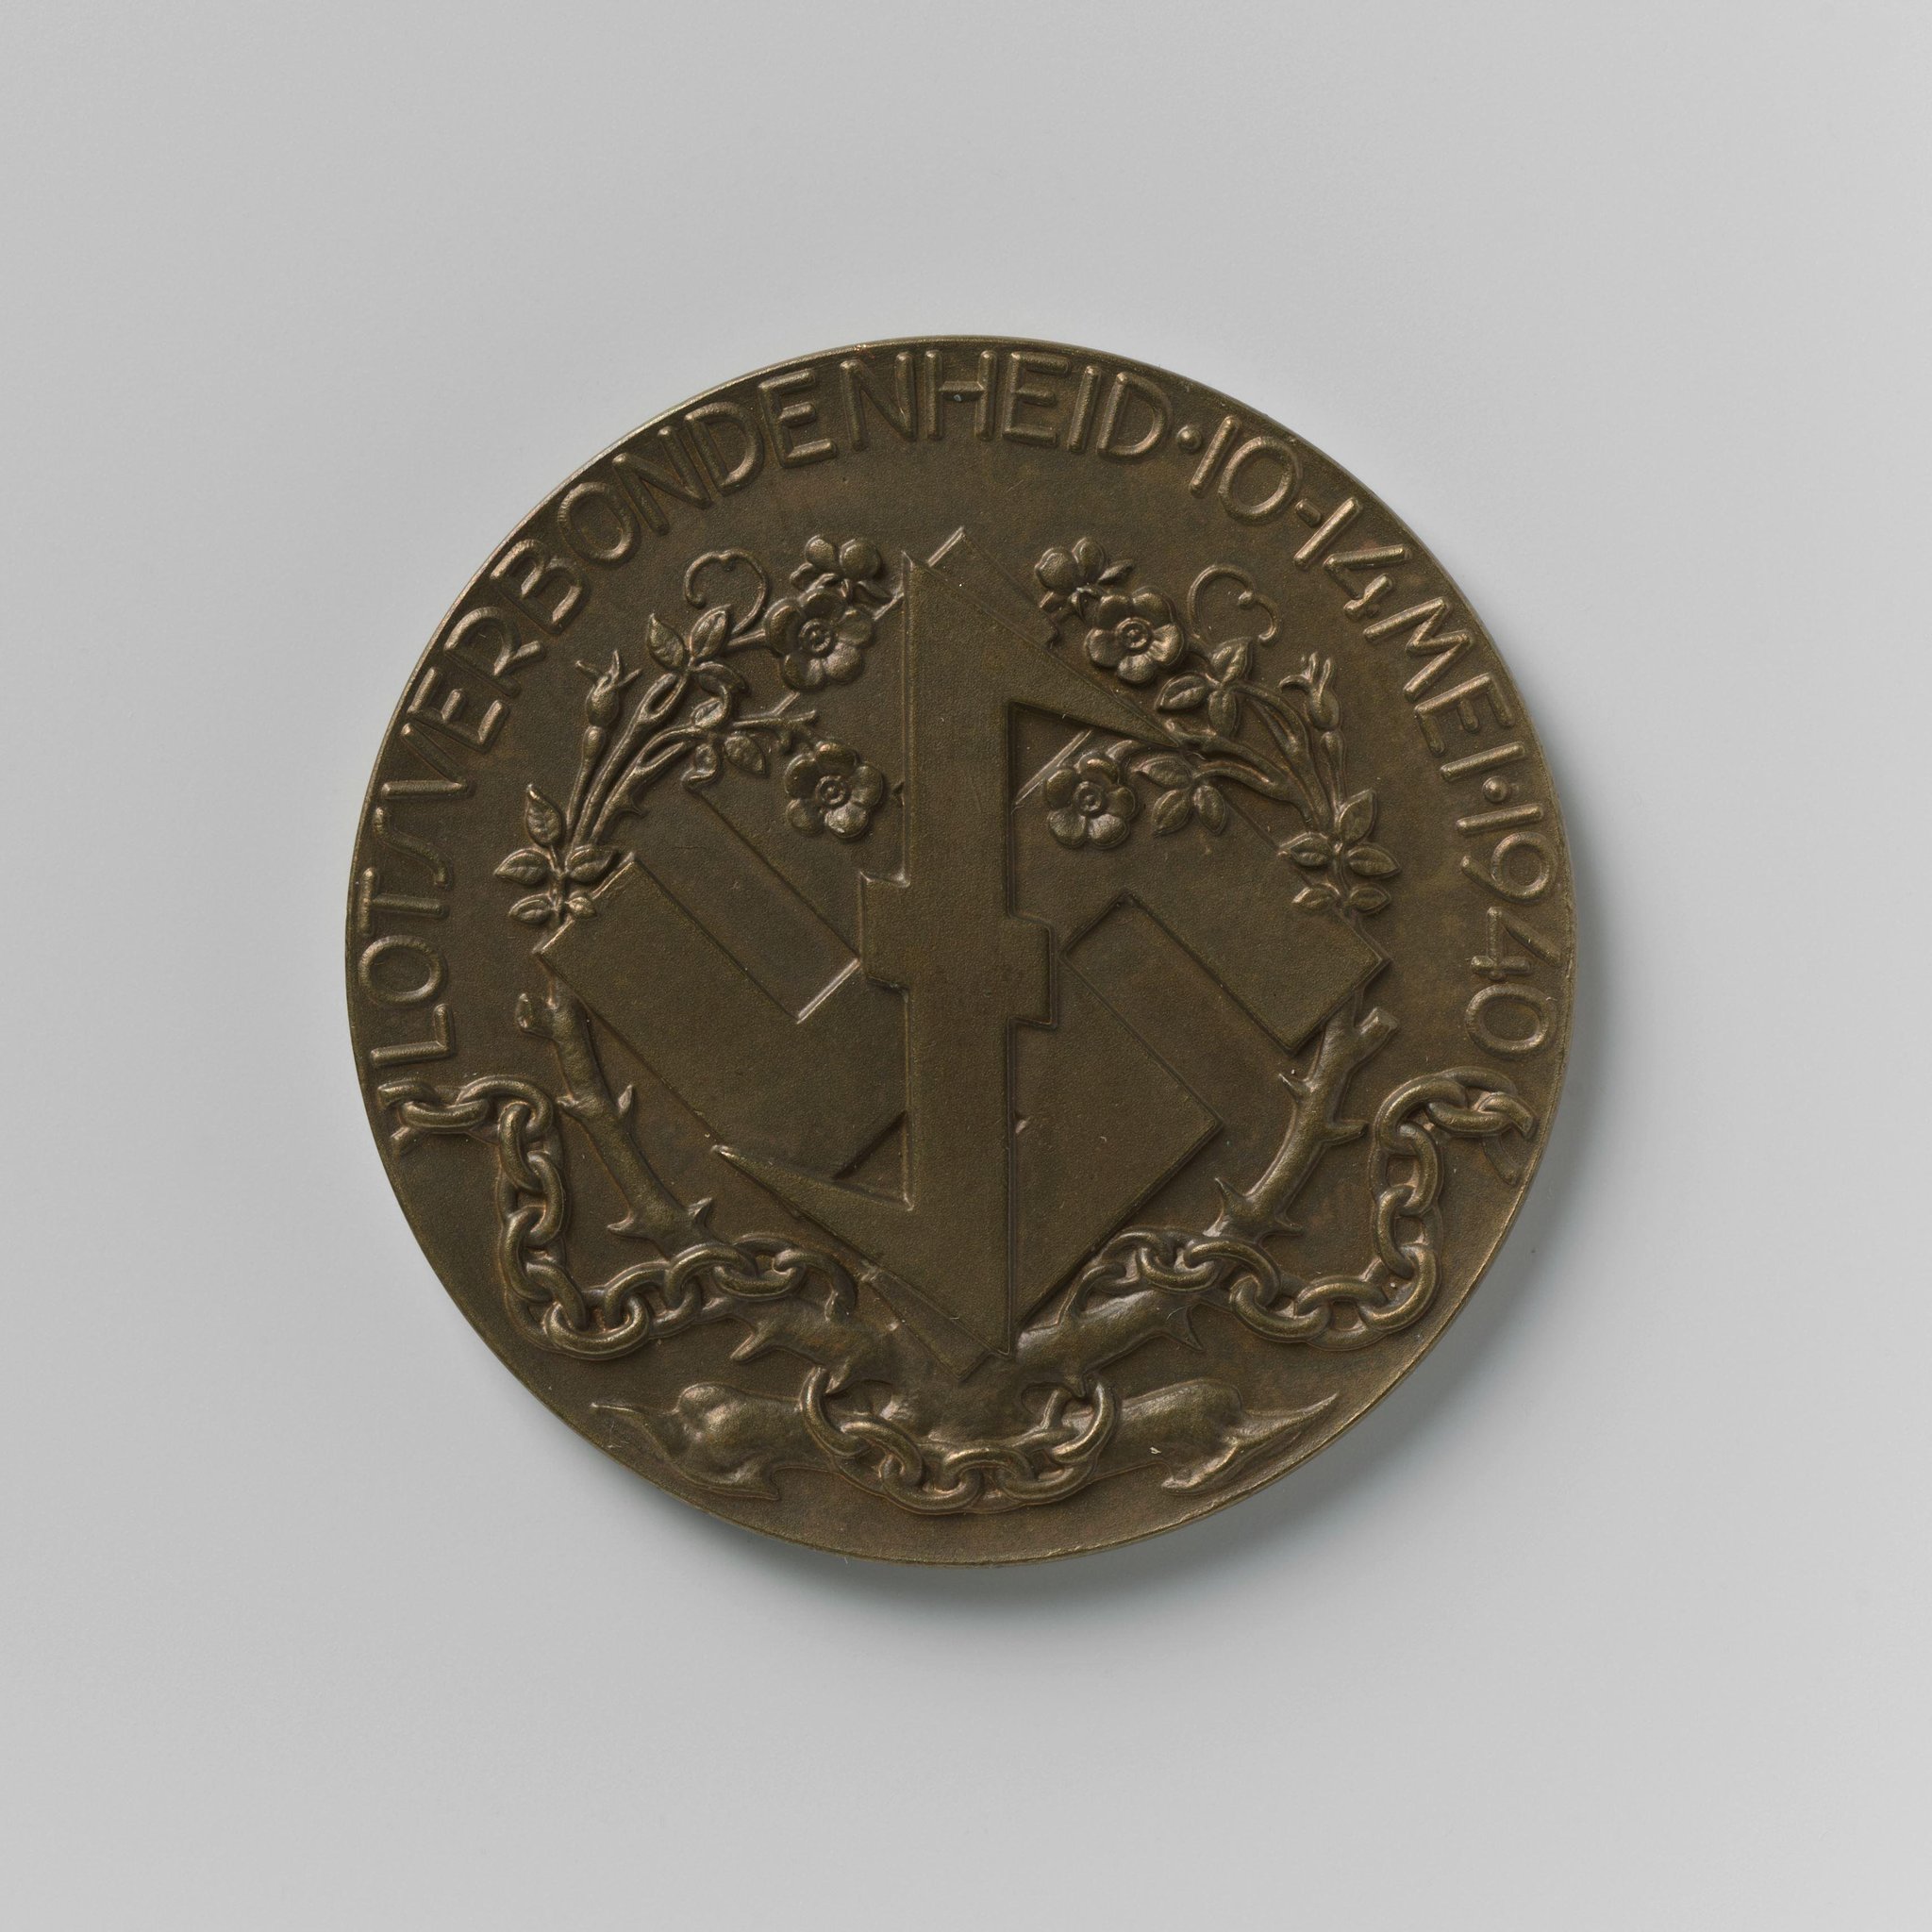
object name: history medal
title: Lotsverbondenheid van Nederlanders en Duitsers 1940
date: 1940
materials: bronze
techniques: striking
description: Bronzen penning, op de voorzijde hakenkruis en wolfsangel omkranst door een geketende rozenstruik, met omschrift, op de keerzijde vier regels tekst.